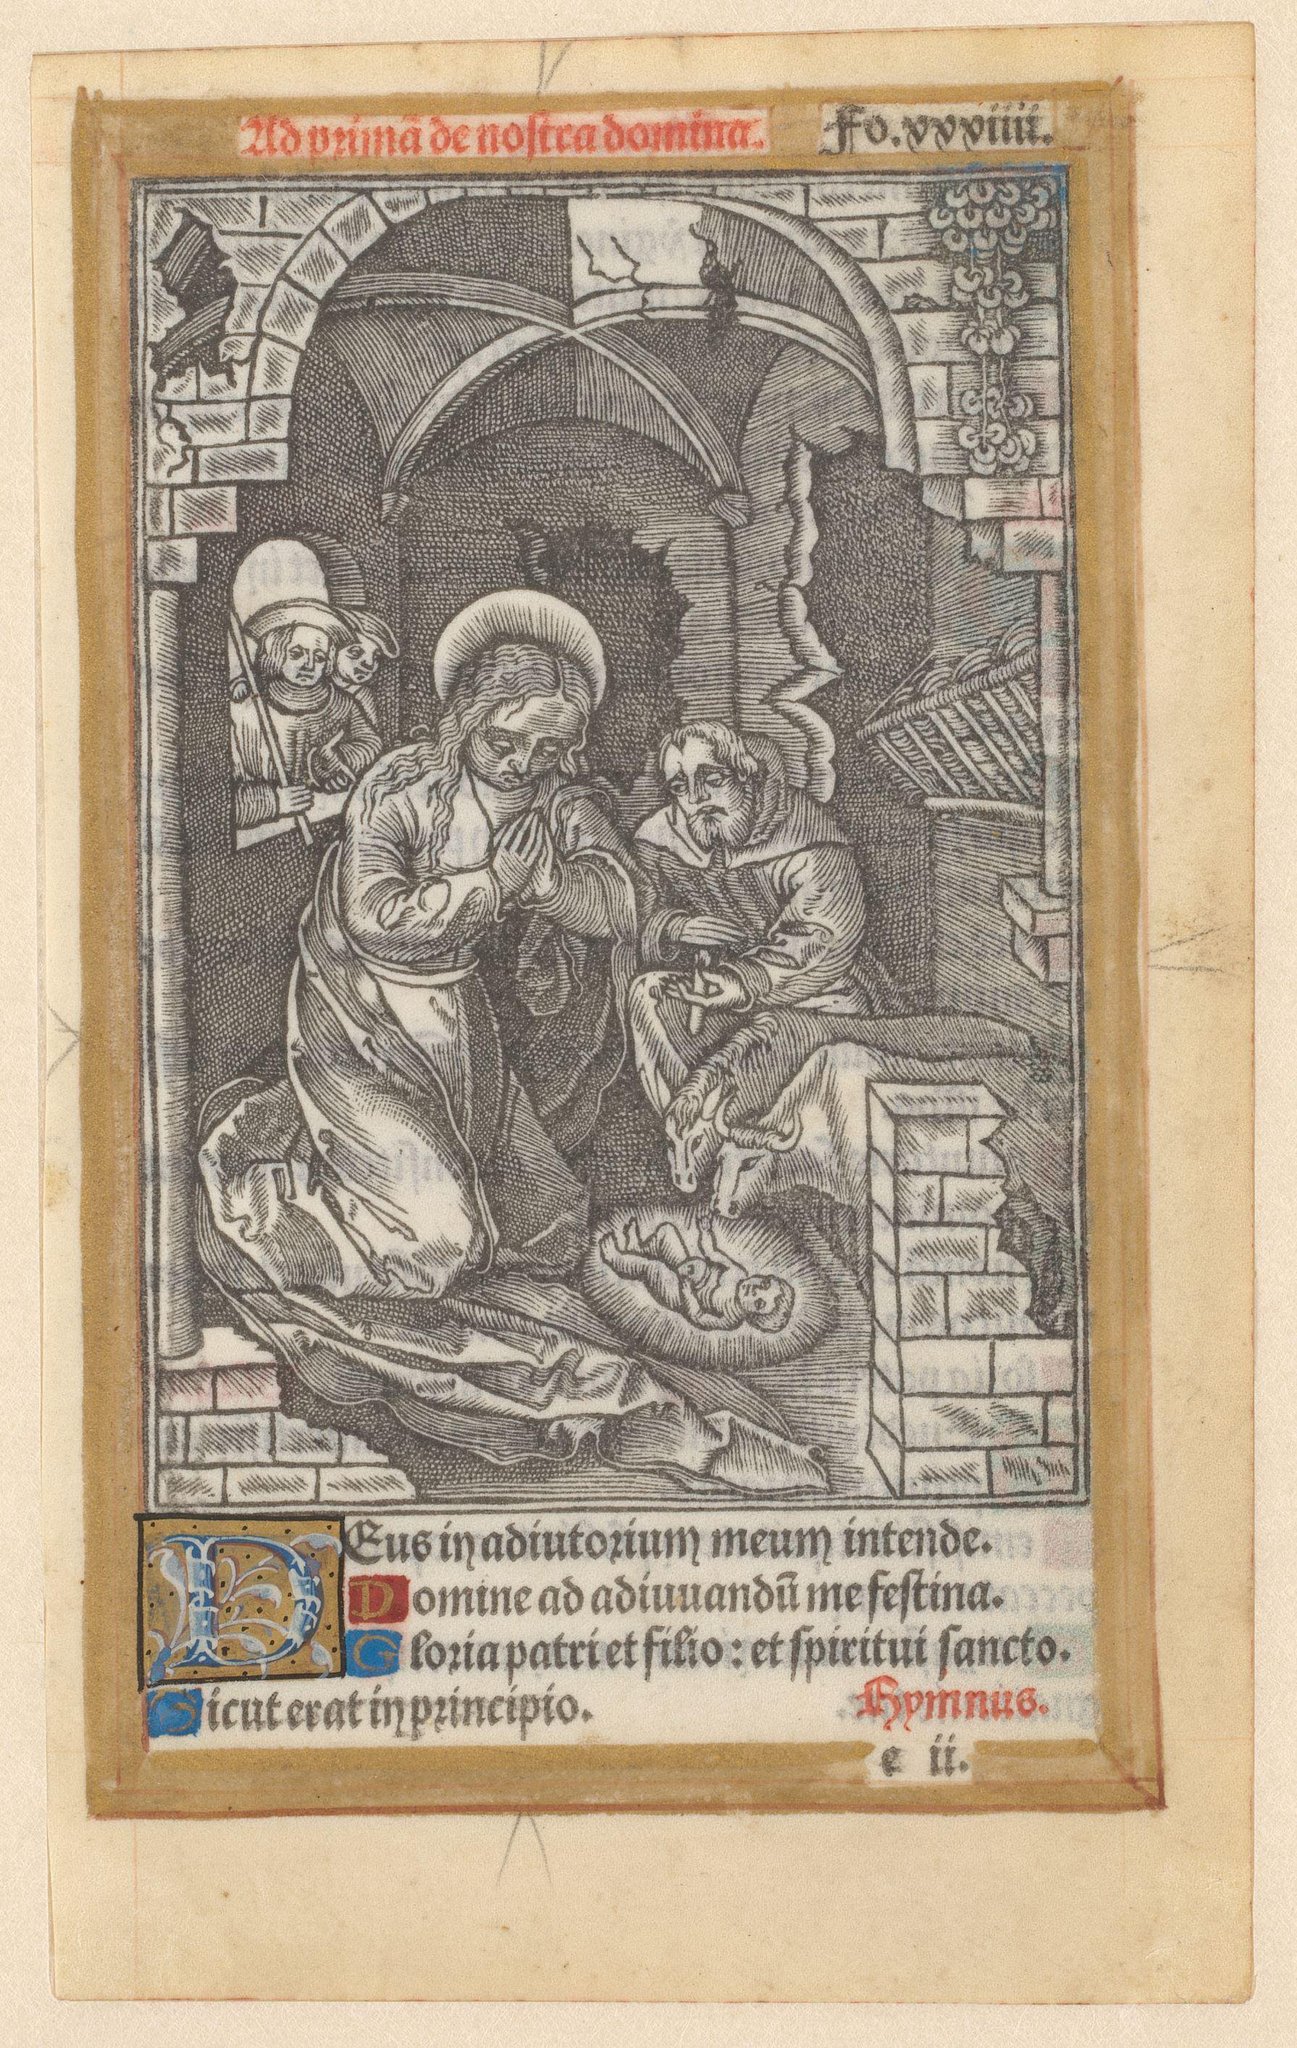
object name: drawing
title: Blad uit een getijdenboek met de Geboorte van Christus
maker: Anonymous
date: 1500-1599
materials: paint, ink, parchment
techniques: brush, engraving, pen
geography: france